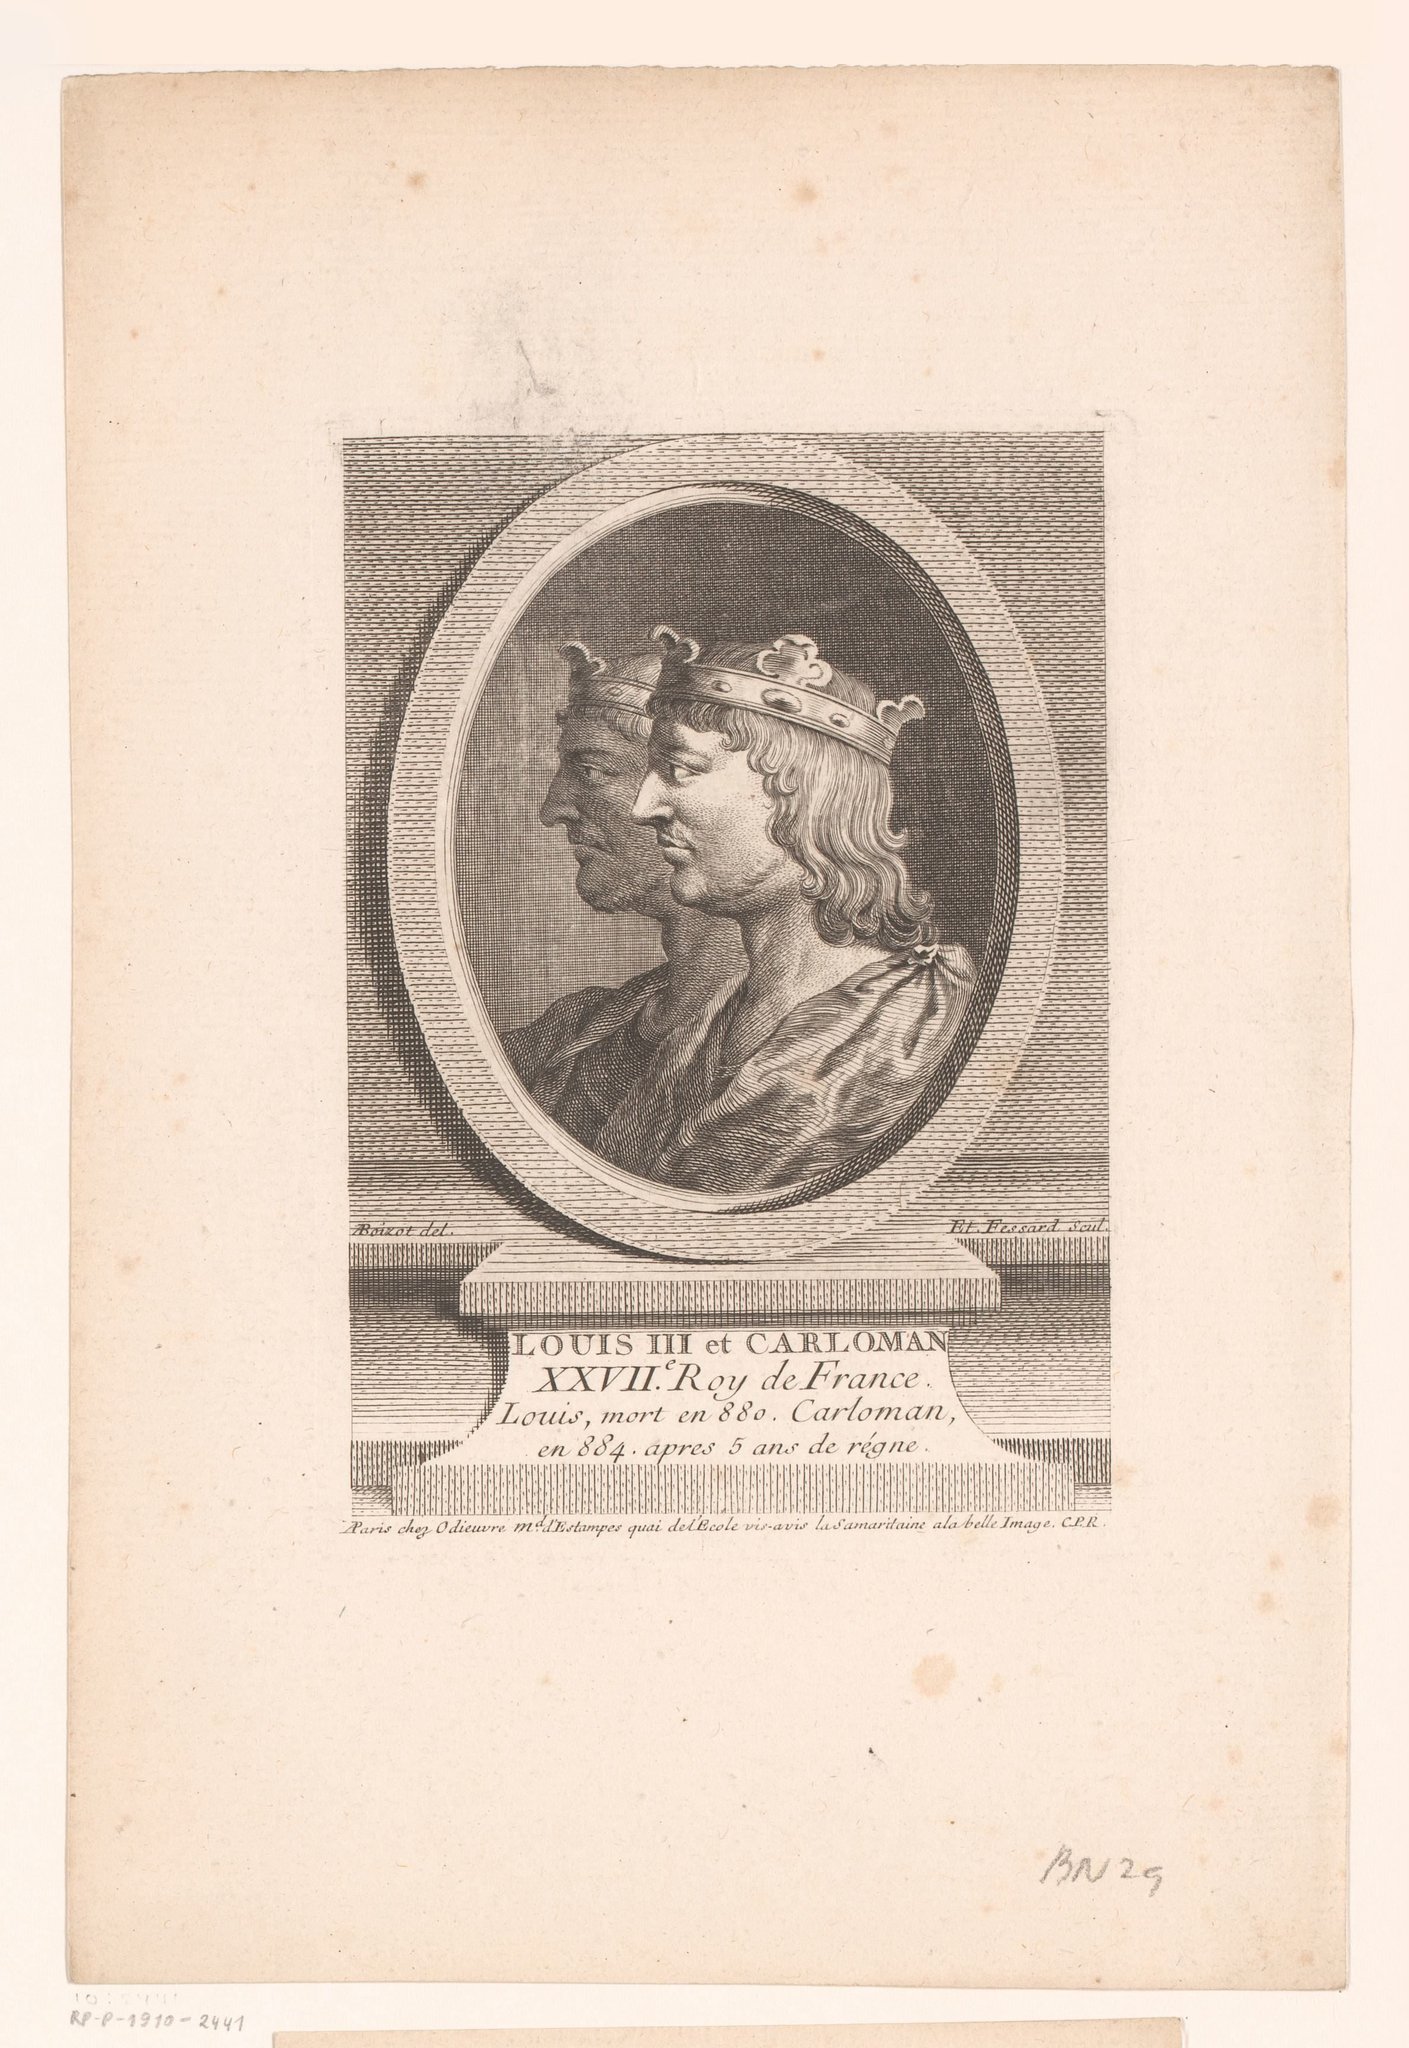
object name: print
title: Portret van Lodewijk III van Frankrijk en Karloman II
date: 1741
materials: paper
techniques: engraving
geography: france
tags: ornament ~ medallion, historical persons, ruler, sovereign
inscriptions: collector's mark: Lugt 2228